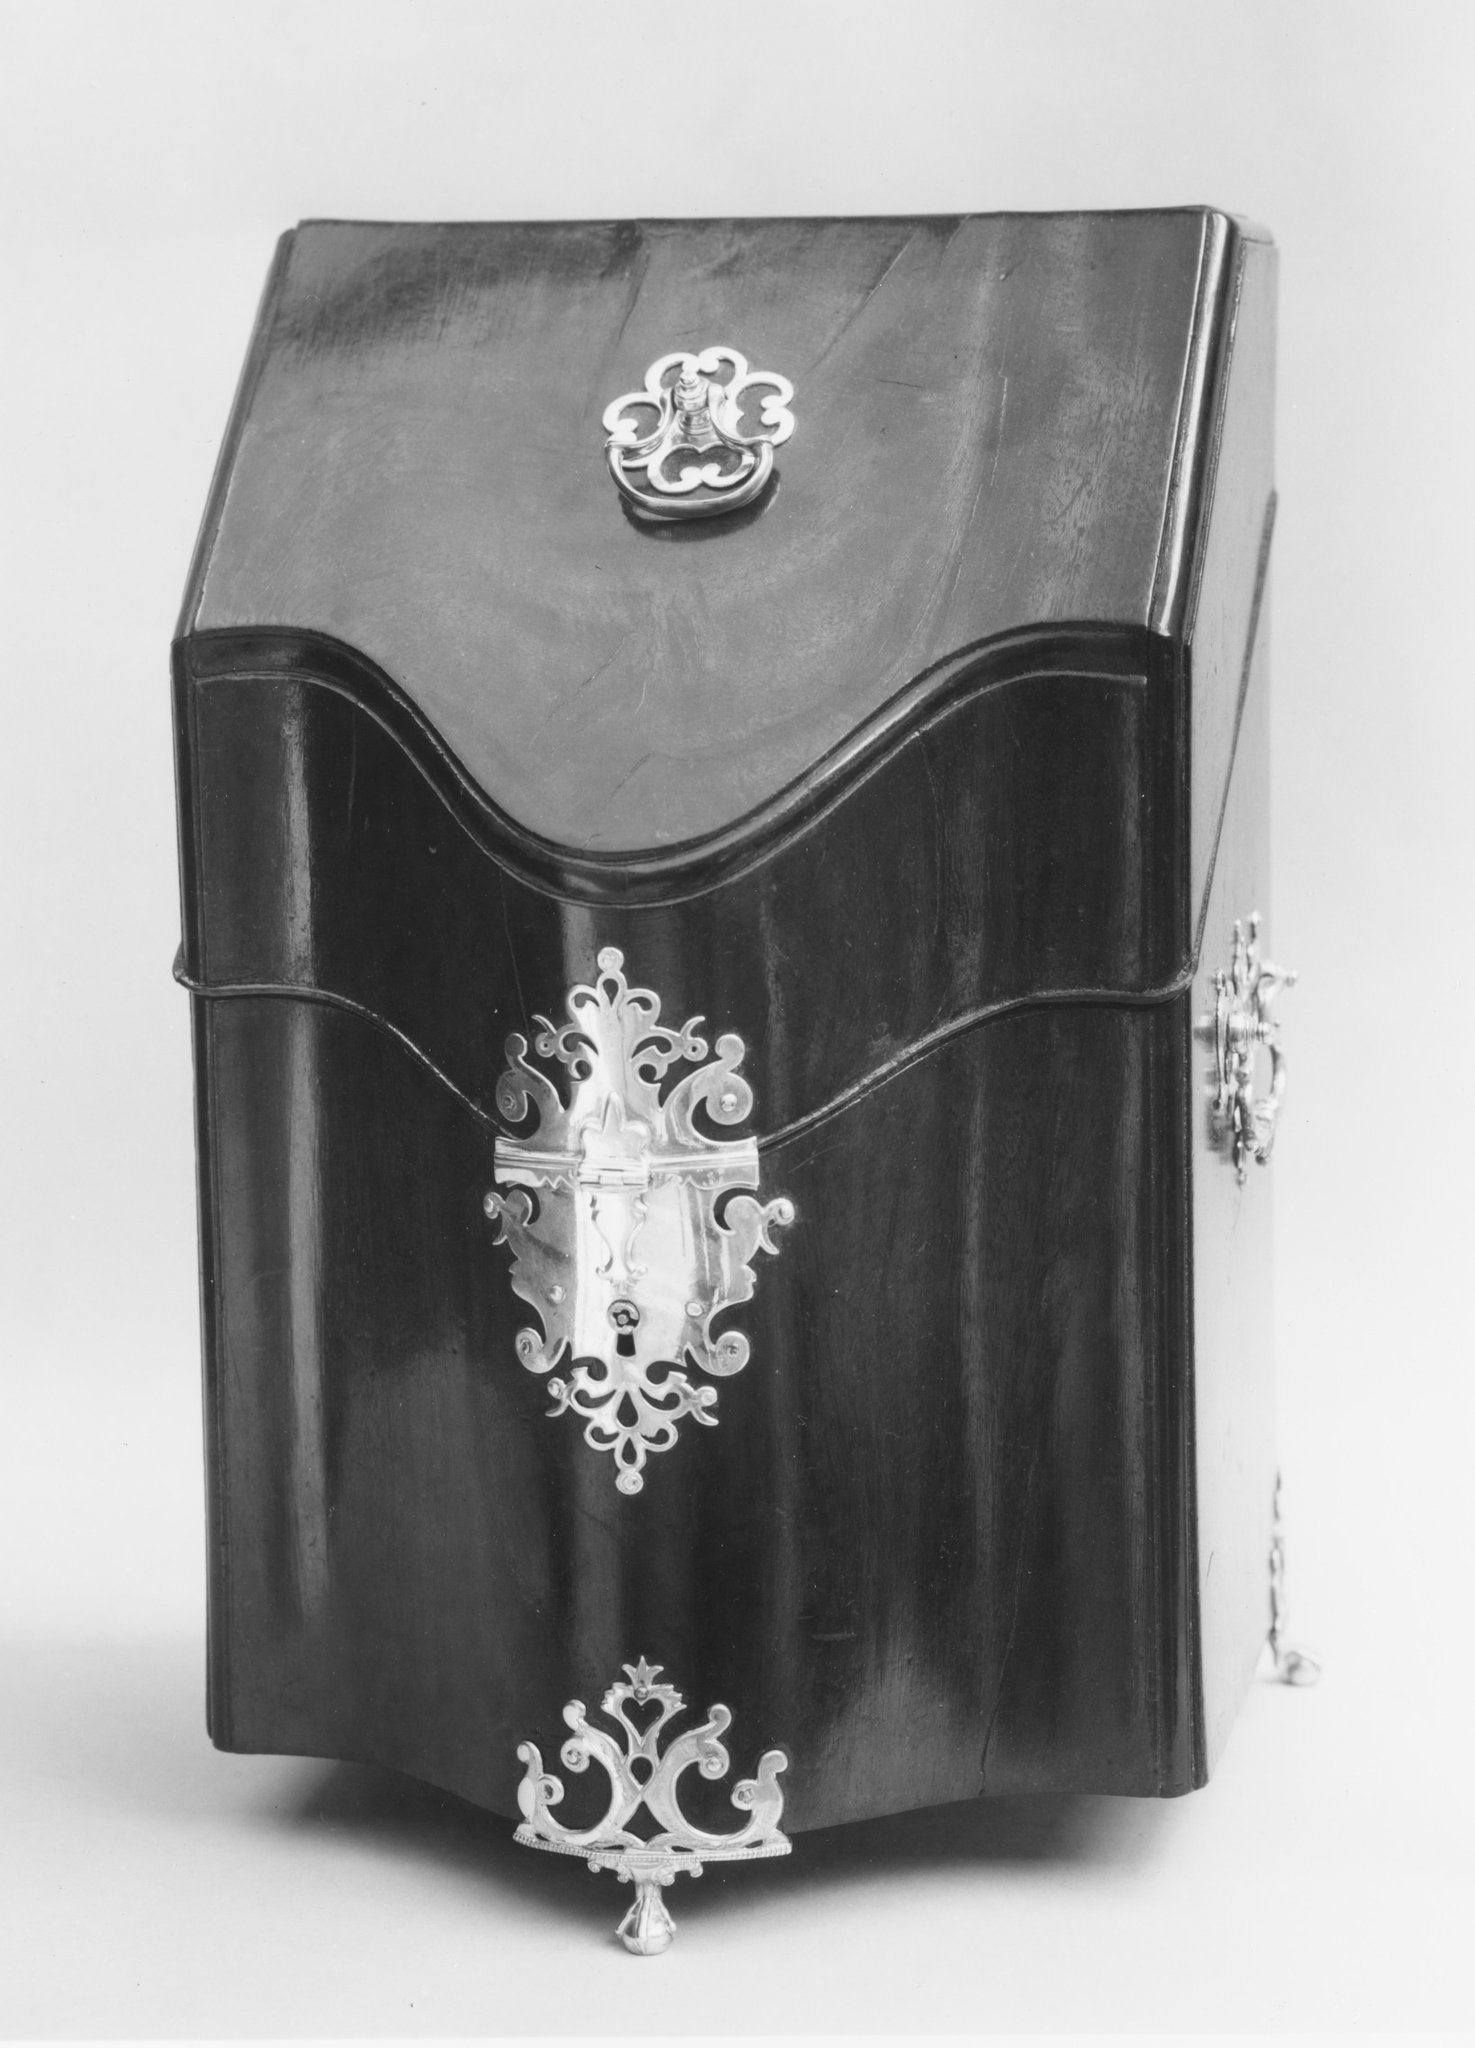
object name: knife box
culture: american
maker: lewis fueter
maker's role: maker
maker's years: 1766-1775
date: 1765-1795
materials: wood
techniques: veneering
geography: united states